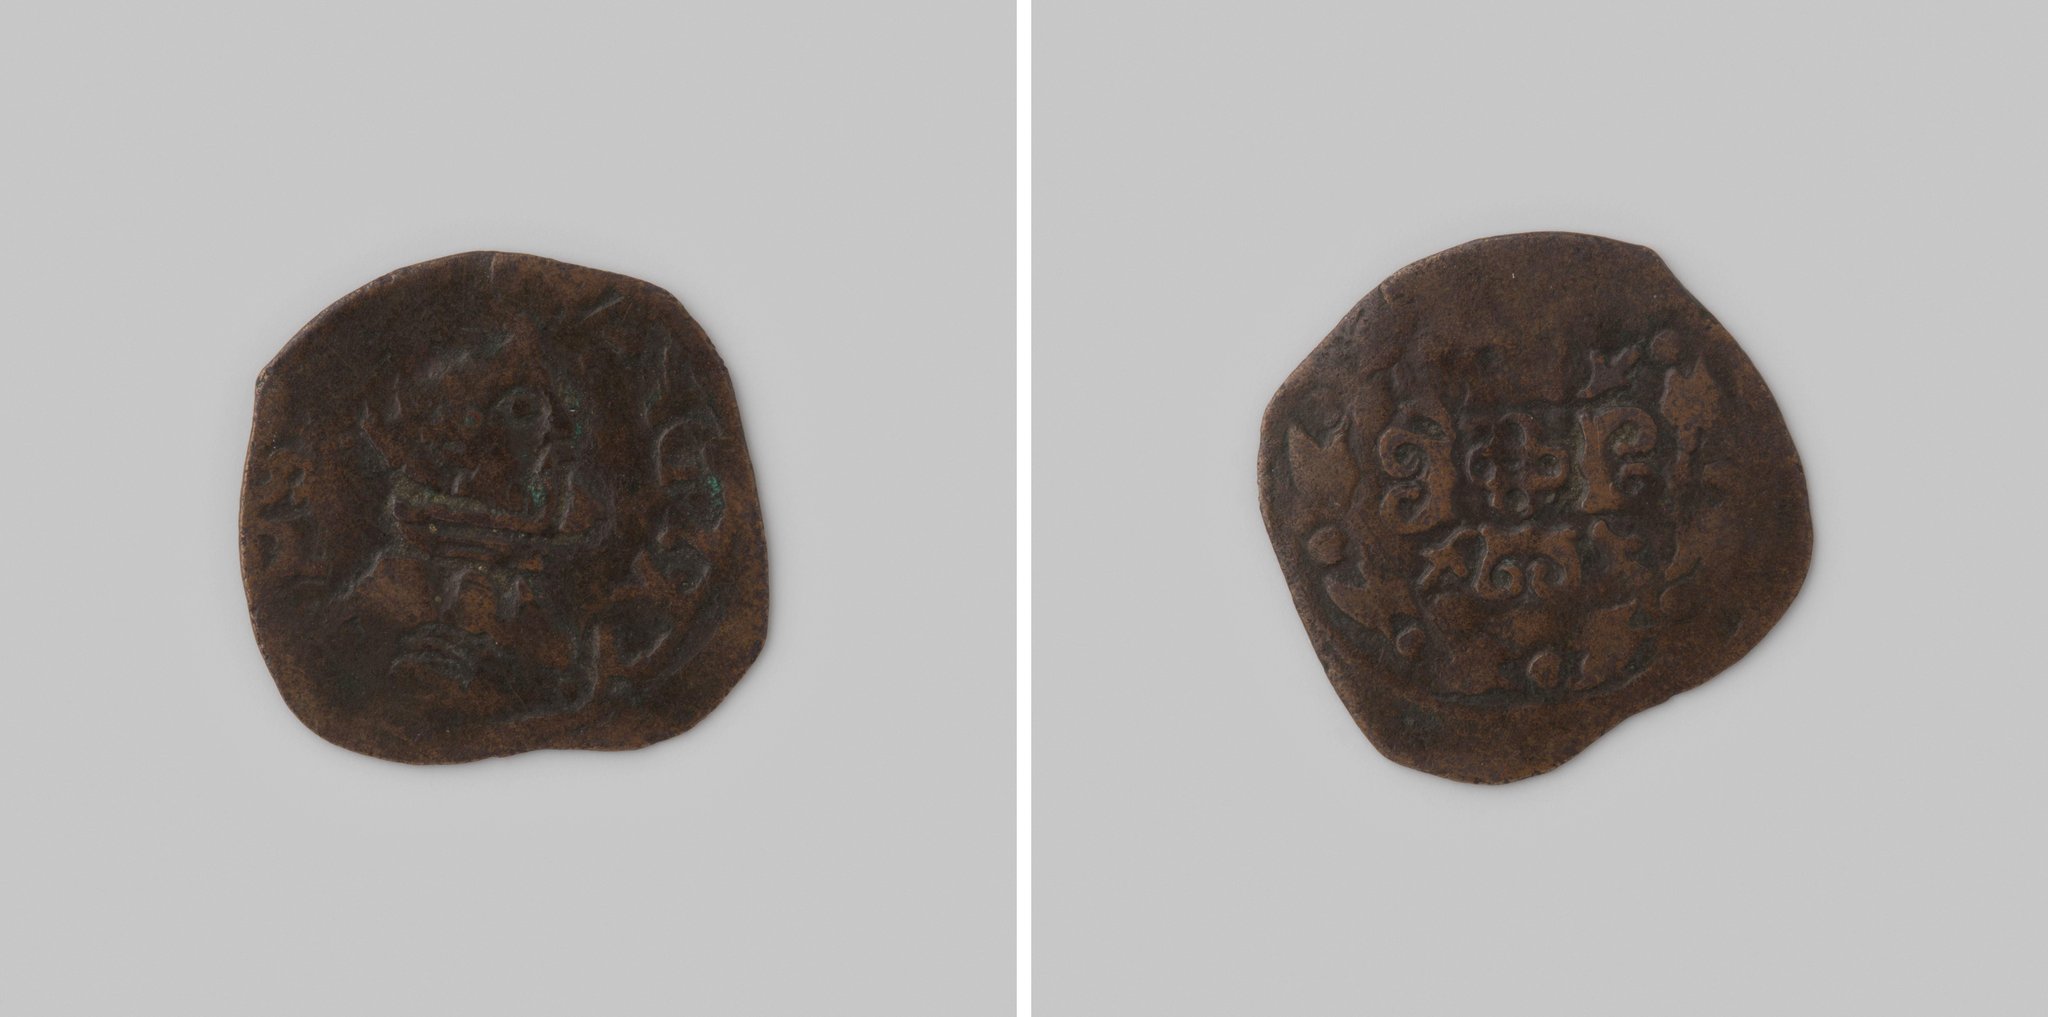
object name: coin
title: Gelderland, Philips II, korte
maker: philip ii of spain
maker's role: koning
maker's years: 1527-1598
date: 1555-1598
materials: copper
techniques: striking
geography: gelderland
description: Koperen munt. Voorzijde: portret Philips II naar rechts. Keerzijde: vier vuurstenen met vonken in kruisvorm.